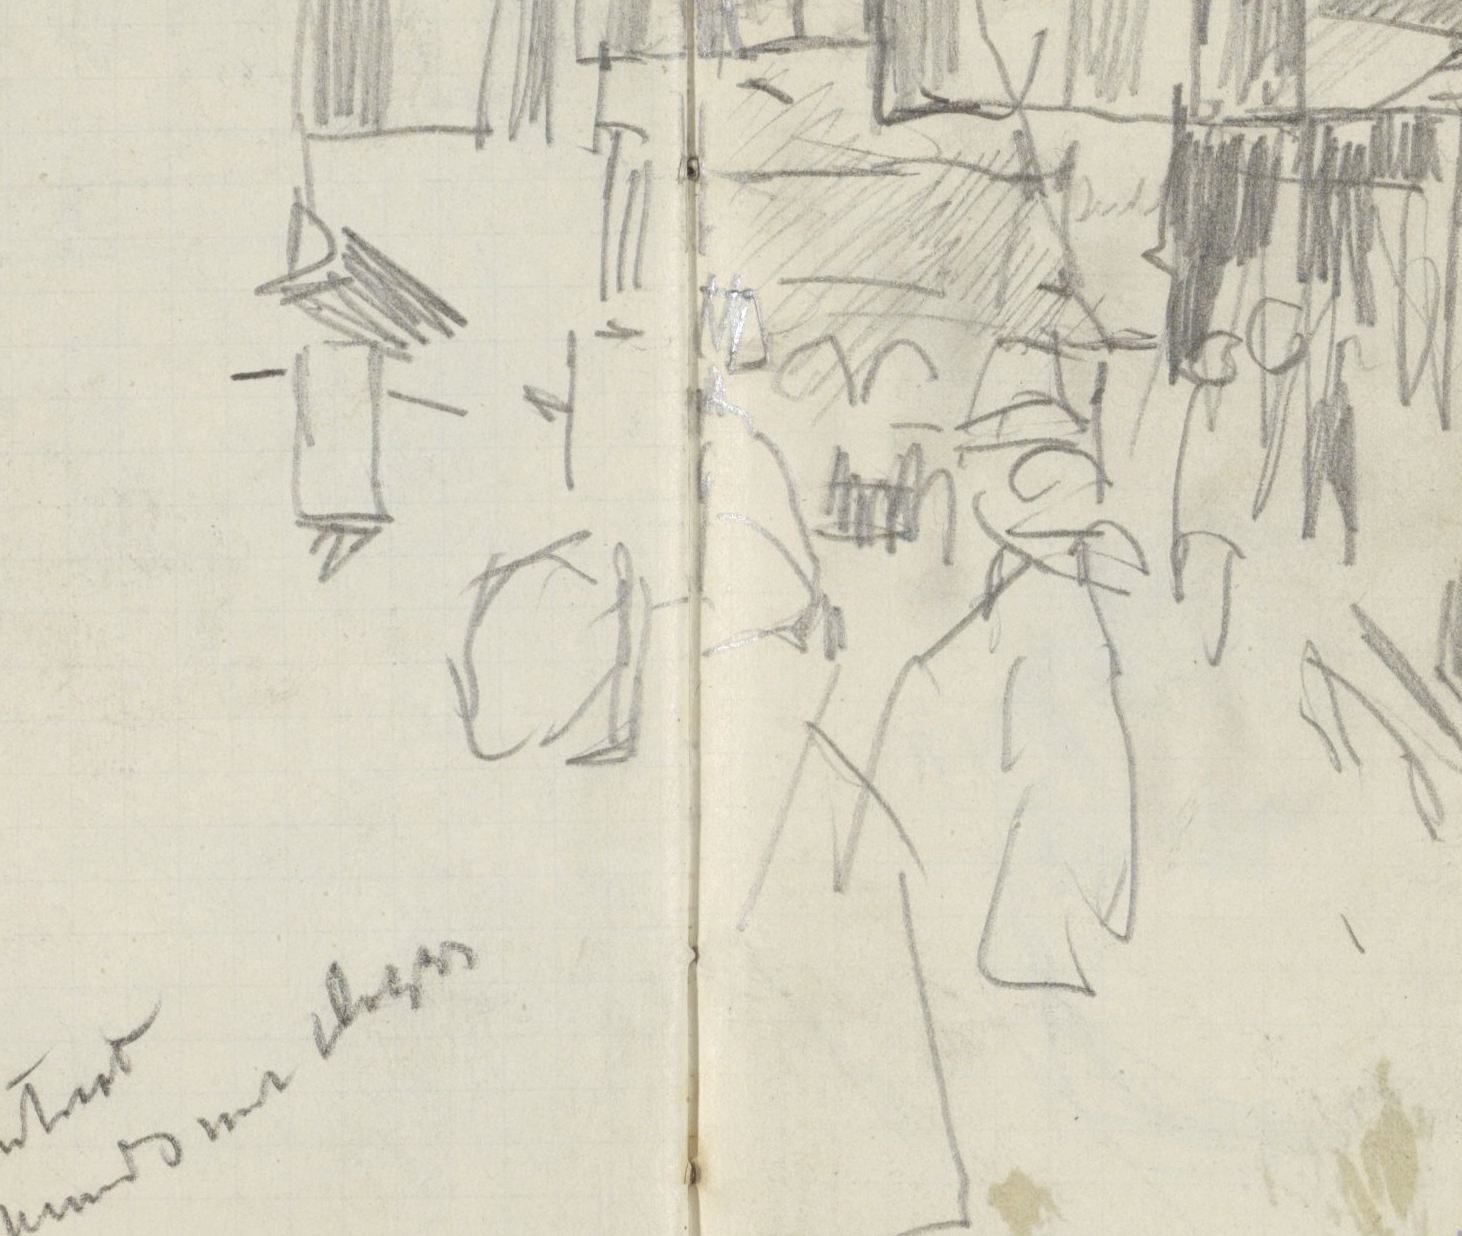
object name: sketchbook leaf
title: Gezicht op de Kalverstraat te Amsterdam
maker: george hendrik breitner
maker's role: draughtsman, painter, print maker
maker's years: 1857-1923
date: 1896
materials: pencil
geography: amsterdam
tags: civic architecture; edifices; dwellings, street (+ city(-scape) with figures, staffage)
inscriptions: workshop stamp: Lugt 291d, annotation: ‘Kalverstraat/ 's avonds met [...]’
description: De Kalverstraat 's avonds met vlaggen. Pagina 35 en pagina 36 uit een schetsboek met 20 bladen.